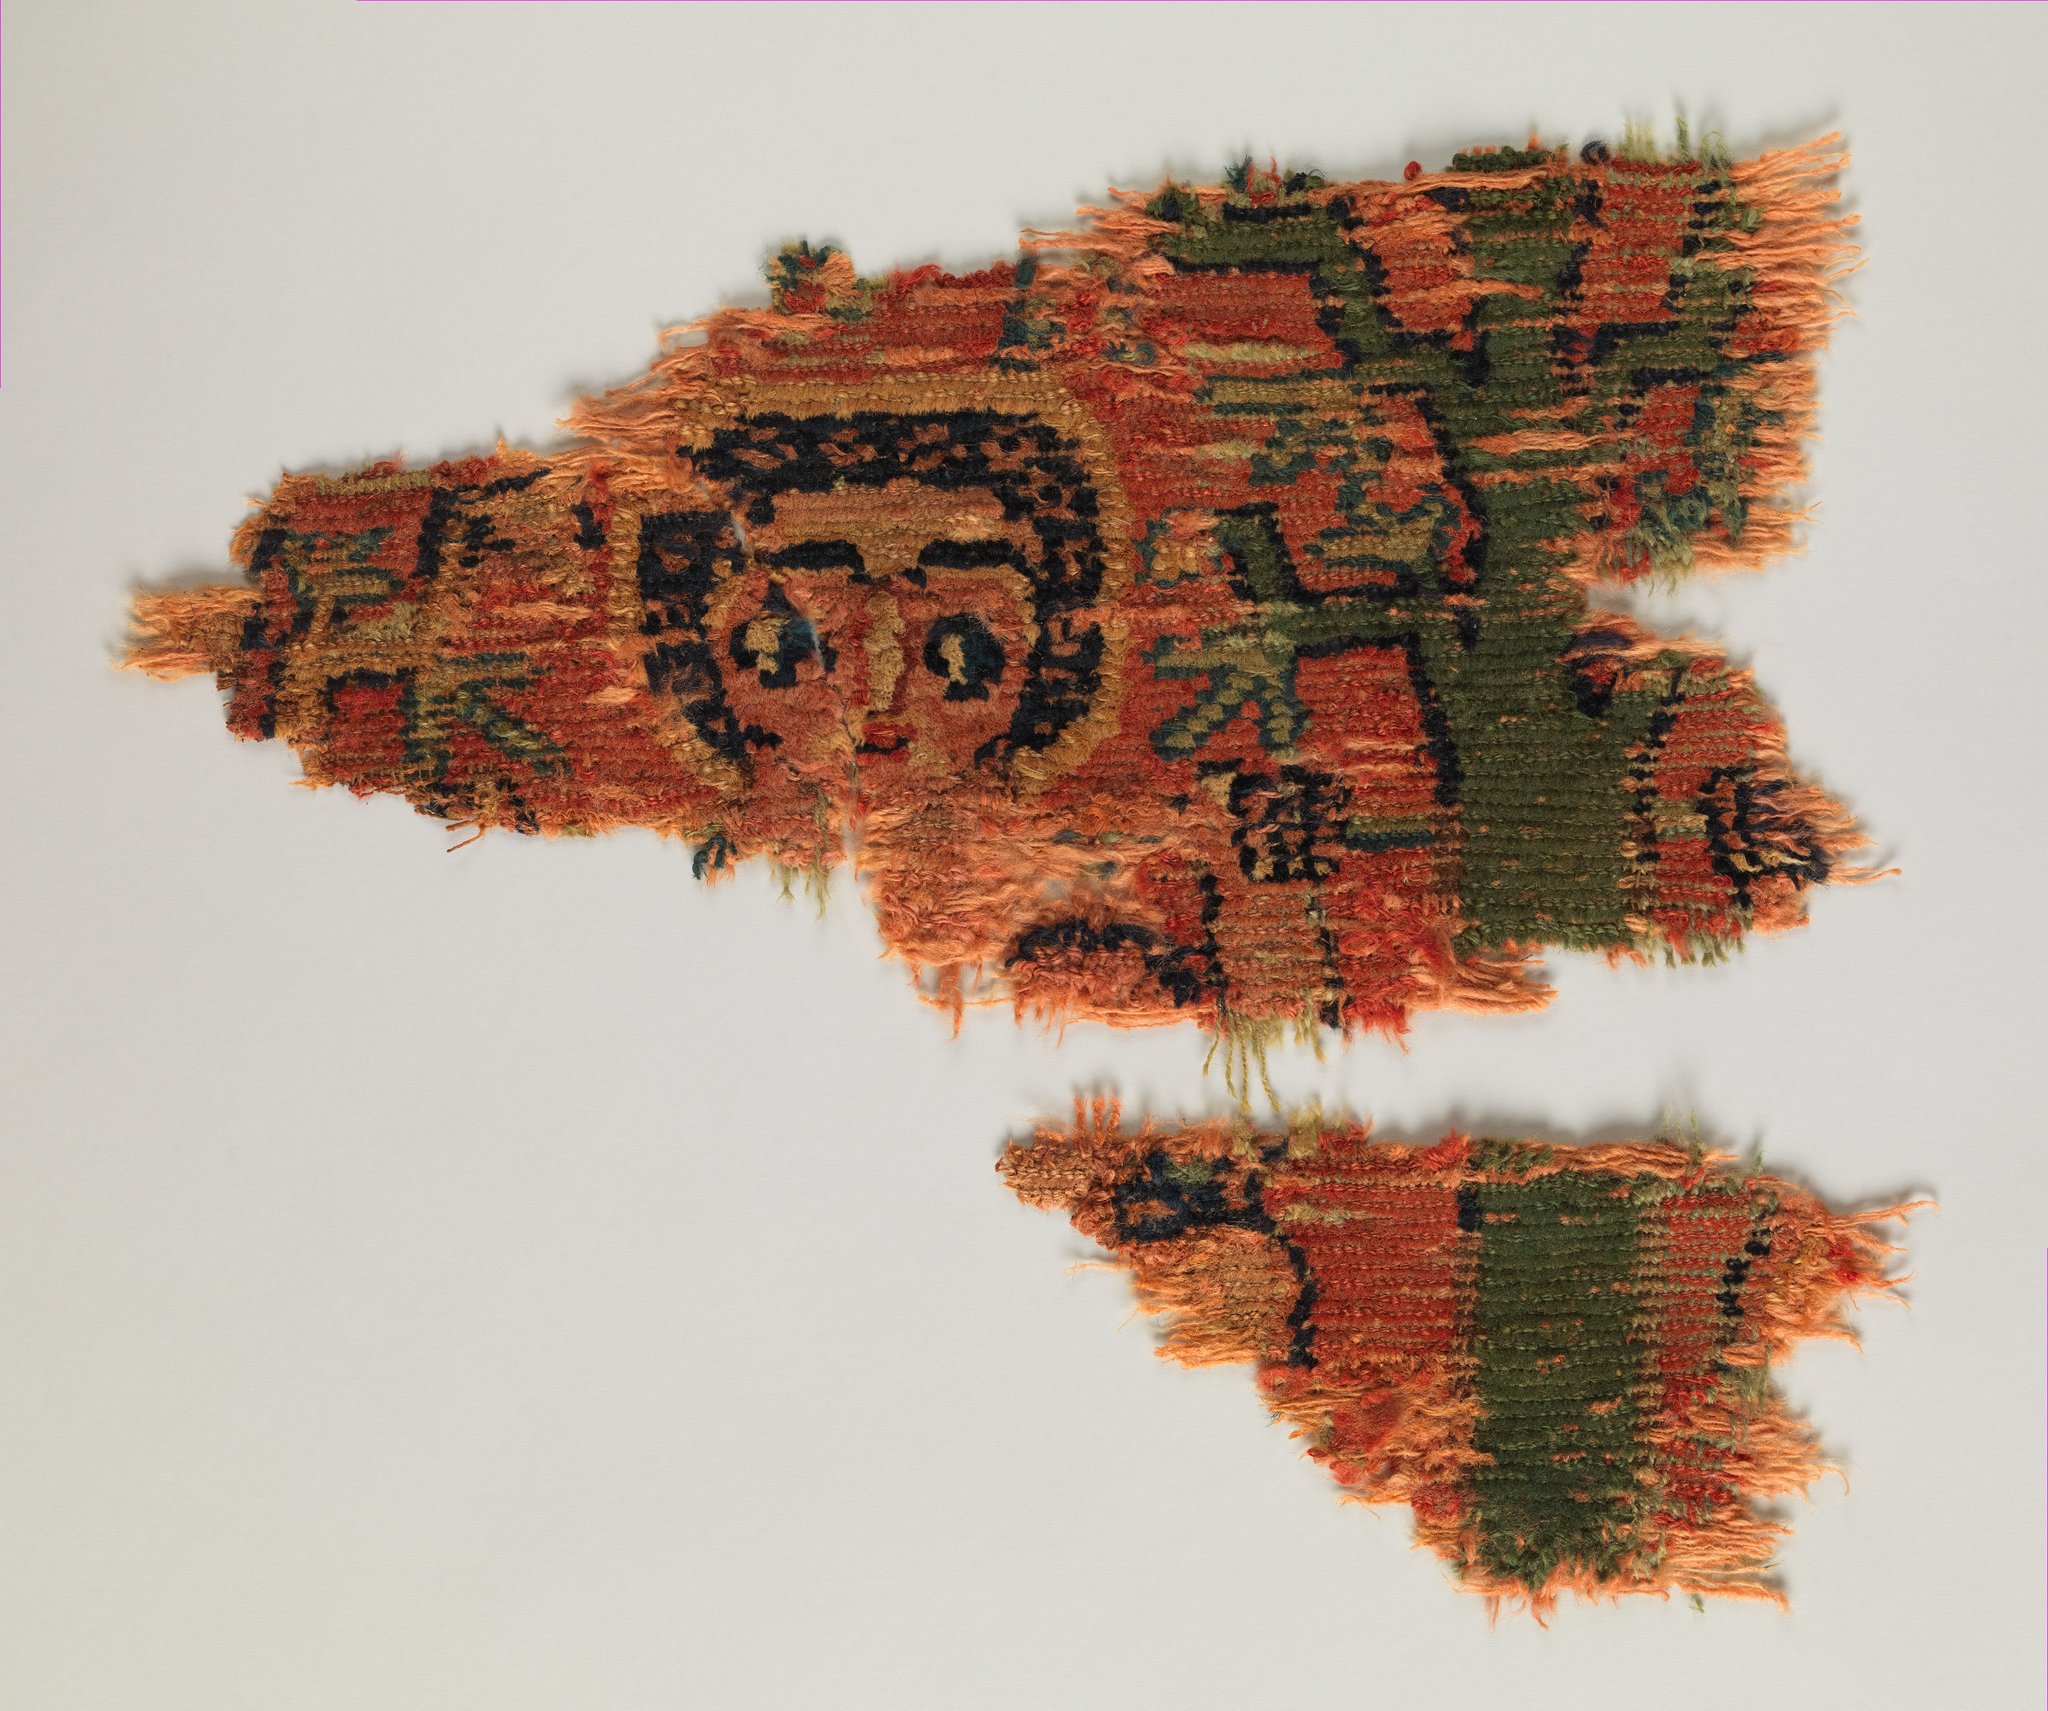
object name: fragment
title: Carpet Fragments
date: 501-800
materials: wool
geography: egypt